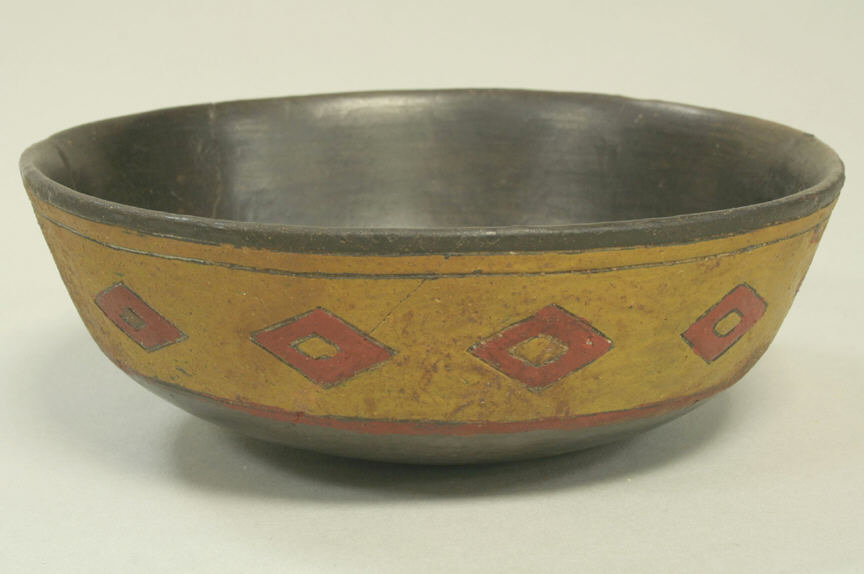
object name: bowl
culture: paracas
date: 700-401 BCE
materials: ceramic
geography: peru